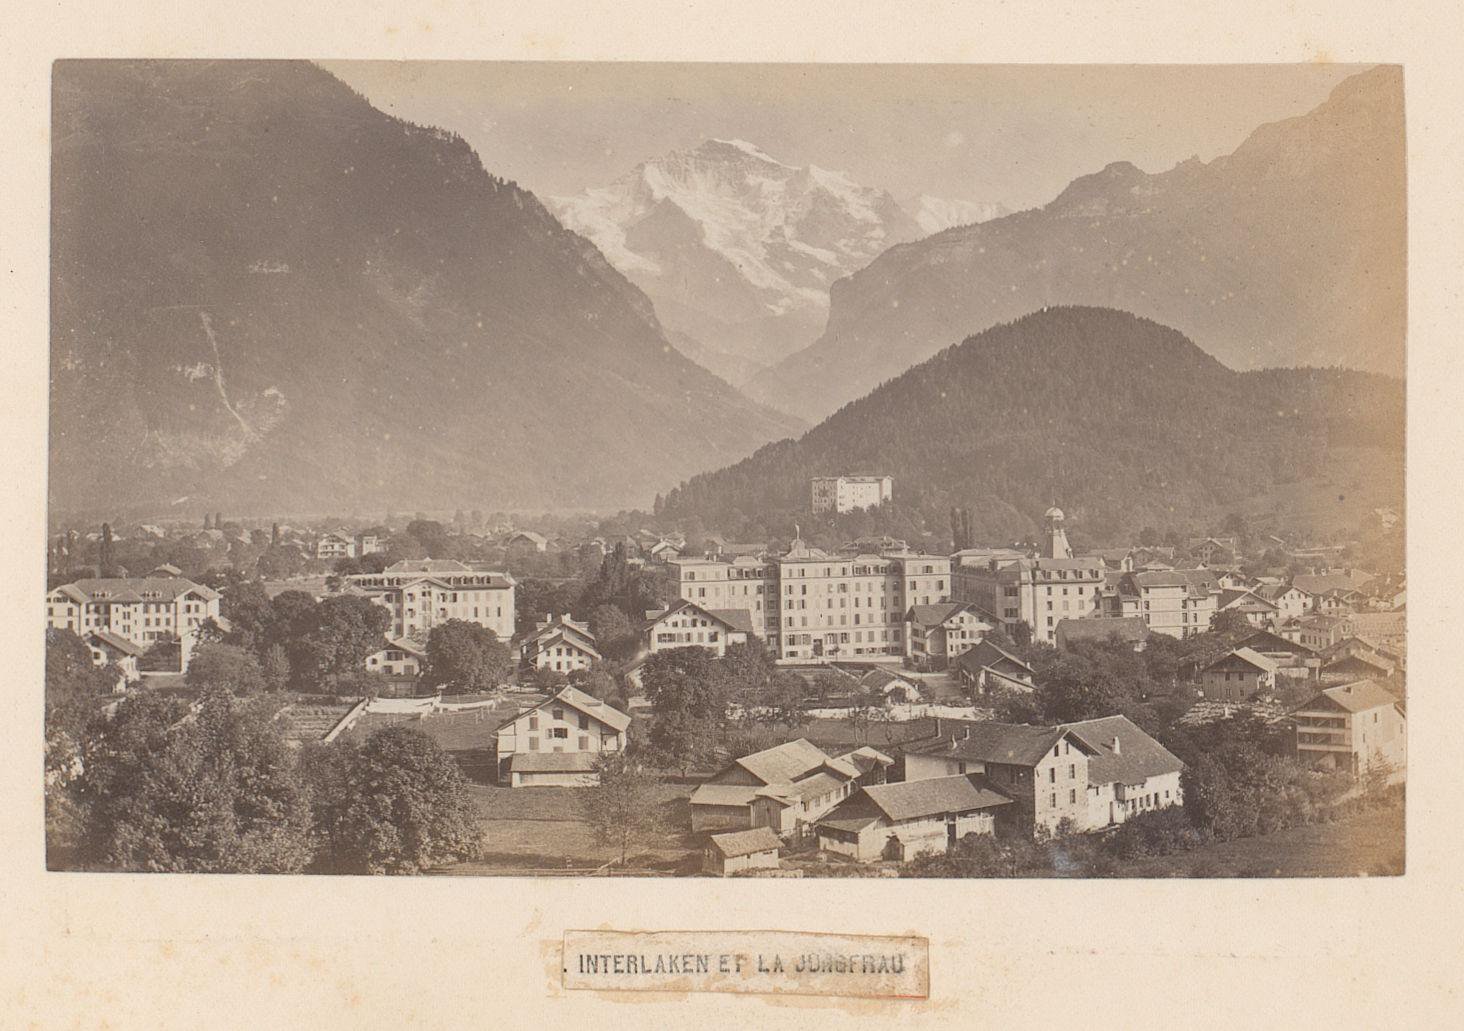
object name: photograph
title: Gezicht op Interlaken met op de achtergrond de Jungfrau, Zwitserland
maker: Anonymous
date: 1860-1890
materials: paper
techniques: albumen print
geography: interlaken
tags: city-view in general; 'veduta', mountains